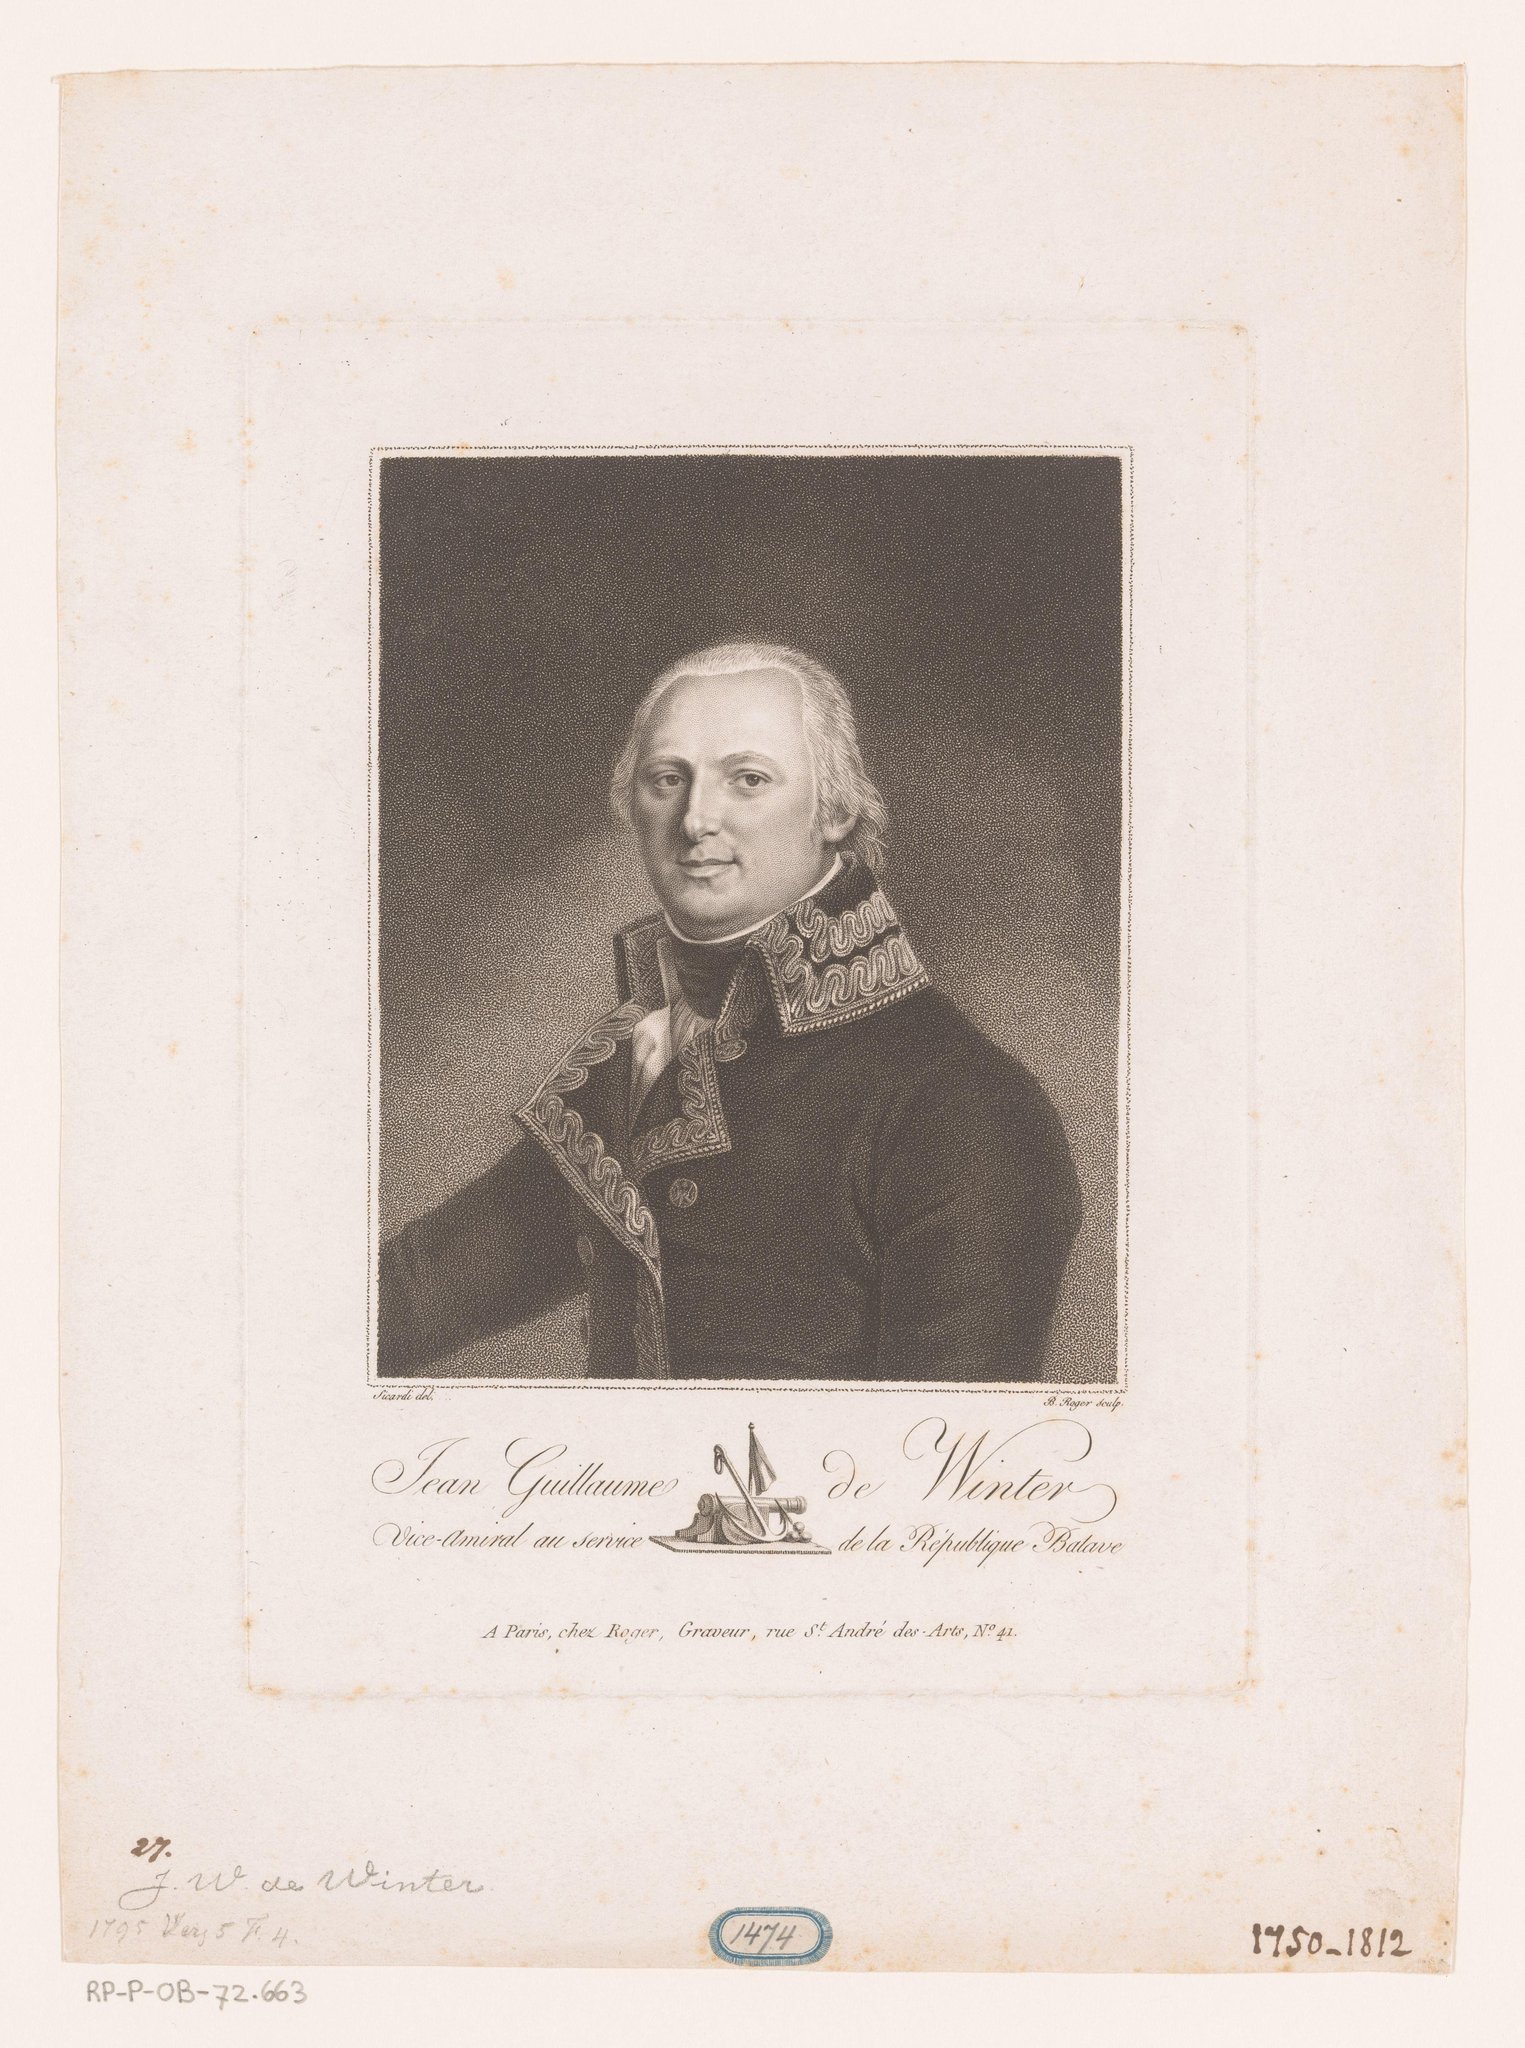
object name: print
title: Portret van Jan Willem de Winter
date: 1777-1840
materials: paper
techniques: etching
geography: paris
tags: paris, jan willem de winter, ranks in the army, historical persons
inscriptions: number: ‘27.’, collector's mark: Lugt 2228